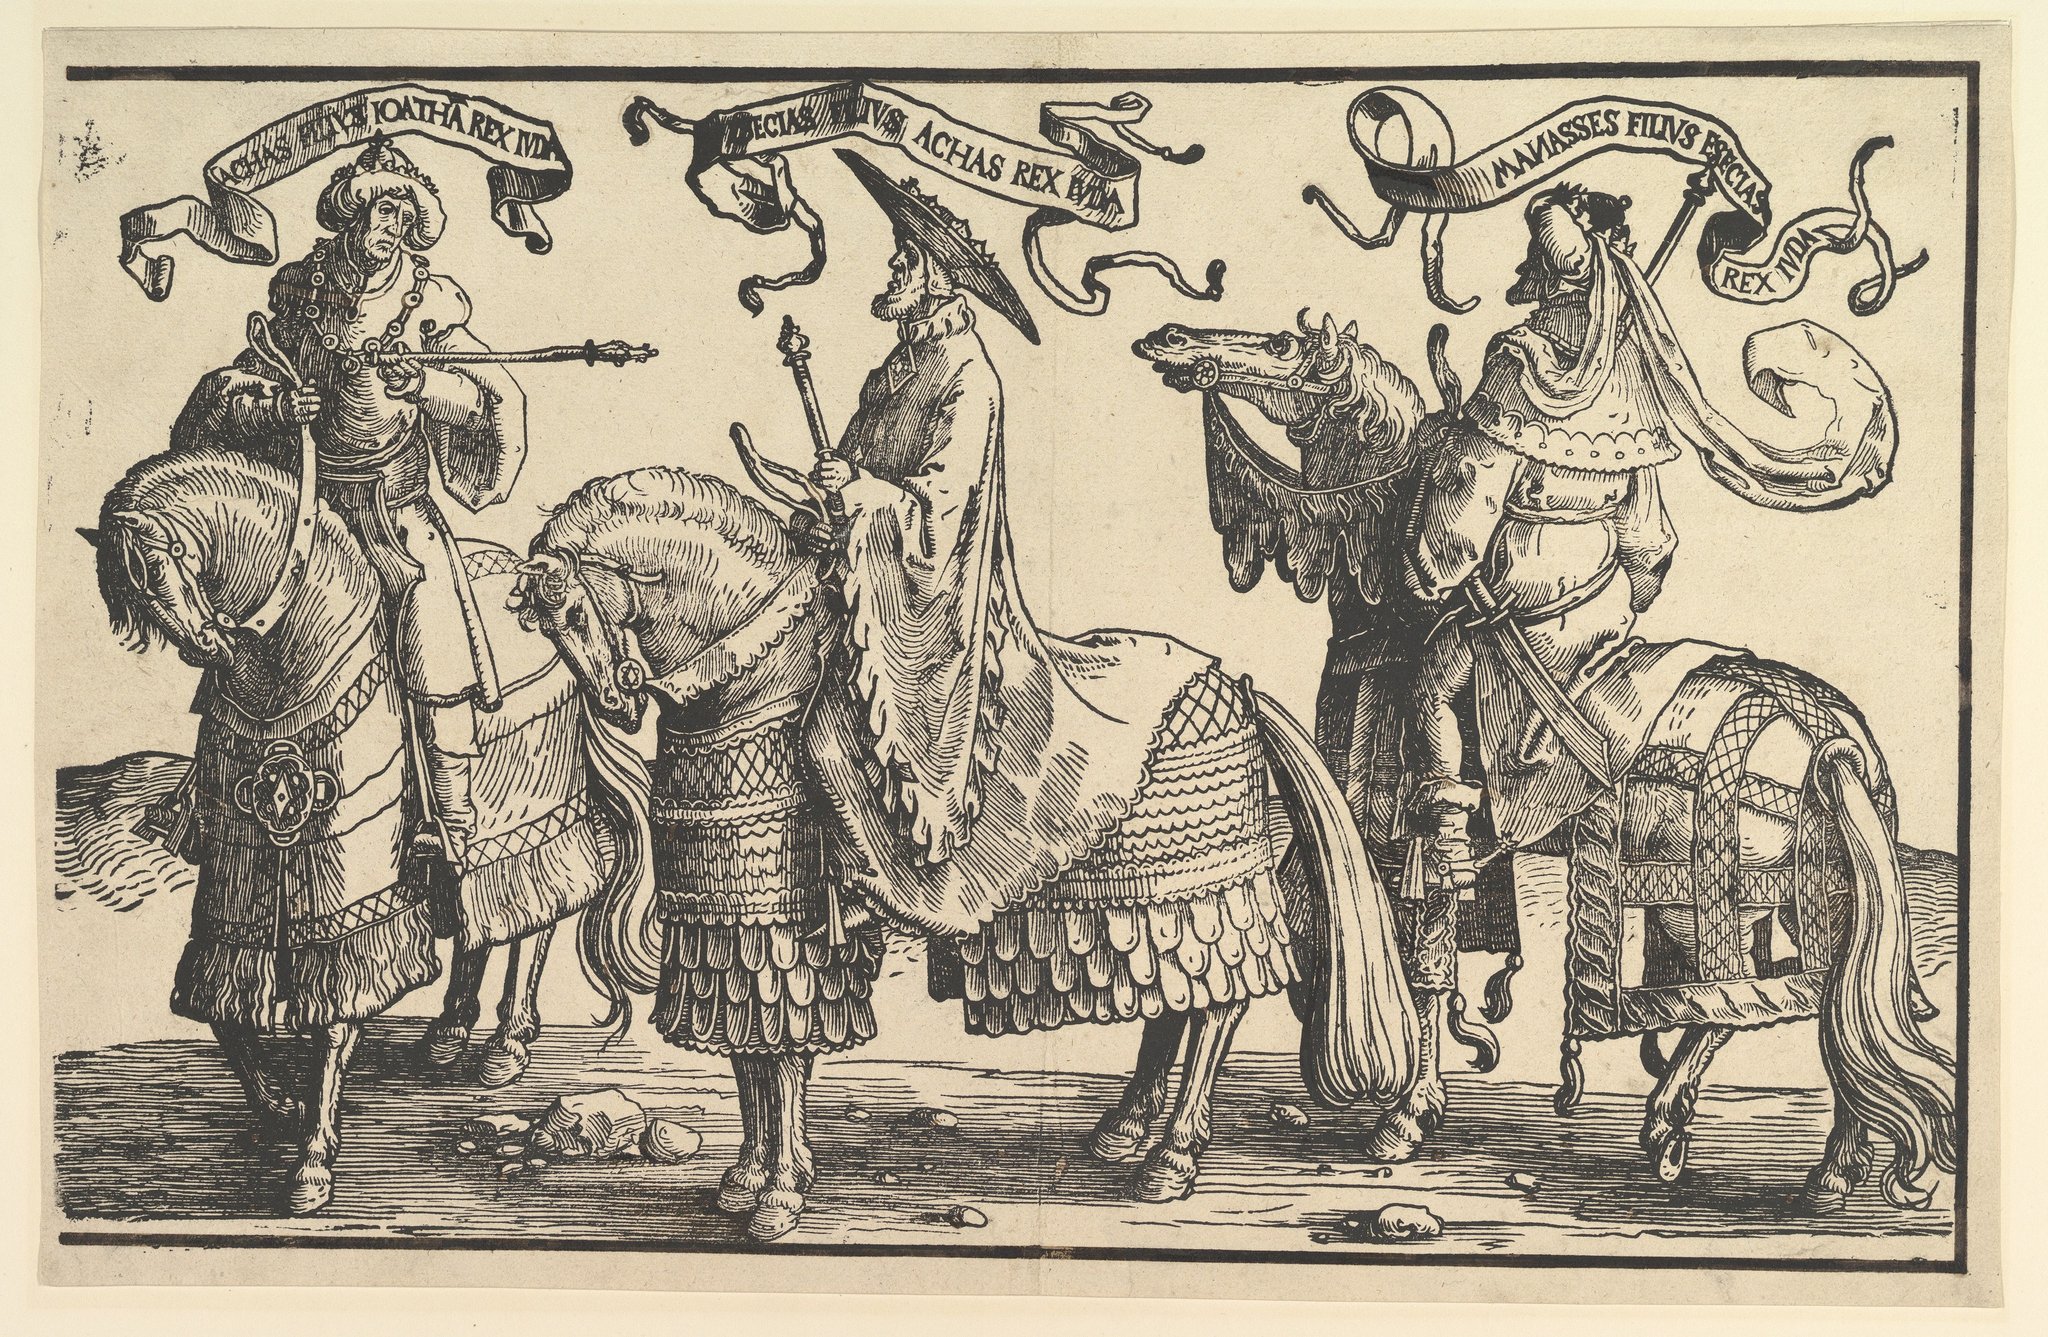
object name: print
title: Ahaz, Hezekiah, Manasses, from The Twelve Kings of Israel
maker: lucas van leyden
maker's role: artist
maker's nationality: netherlandish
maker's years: 1494-1533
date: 1520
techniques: woodcut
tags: kings,horses